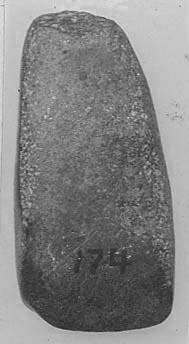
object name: hatchet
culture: swiss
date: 1902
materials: jade